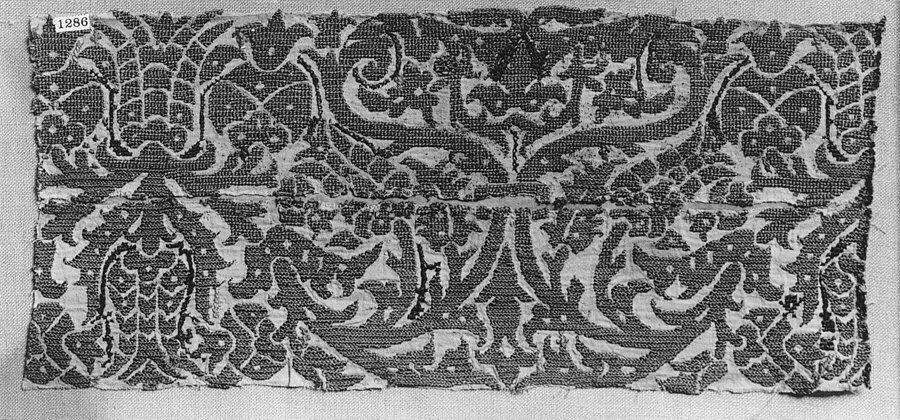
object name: fragment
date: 1501-1600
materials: linen